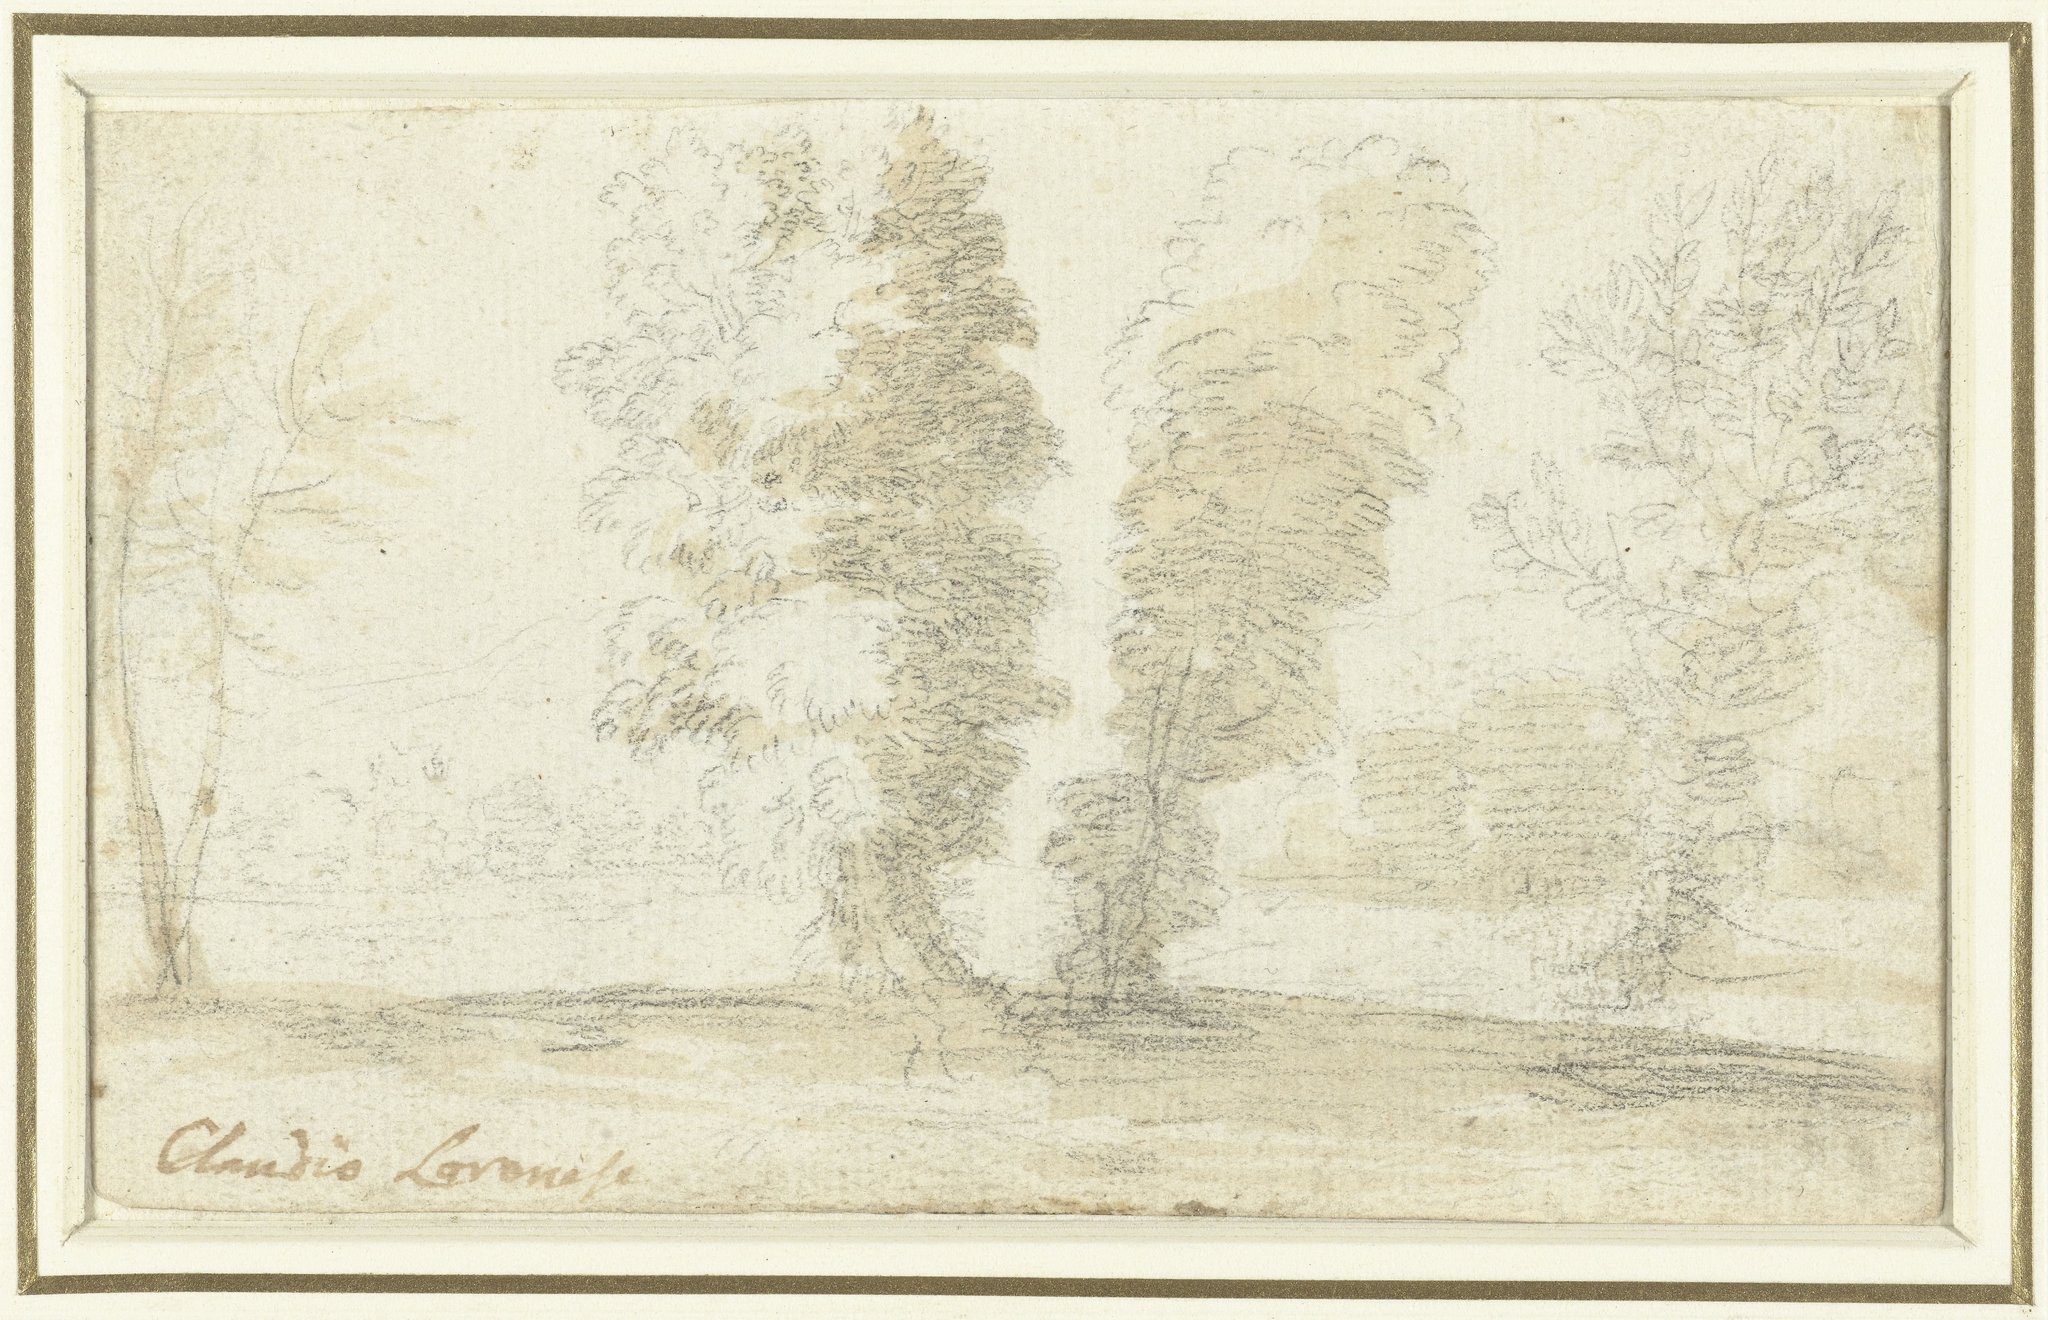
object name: drawing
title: Enkele hoge bomen voor een open veld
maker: claude lorrain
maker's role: draughtsman, print maker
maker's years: 1604-1682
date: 1610-1680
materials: chalk, paper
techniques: brush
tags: groups of trees